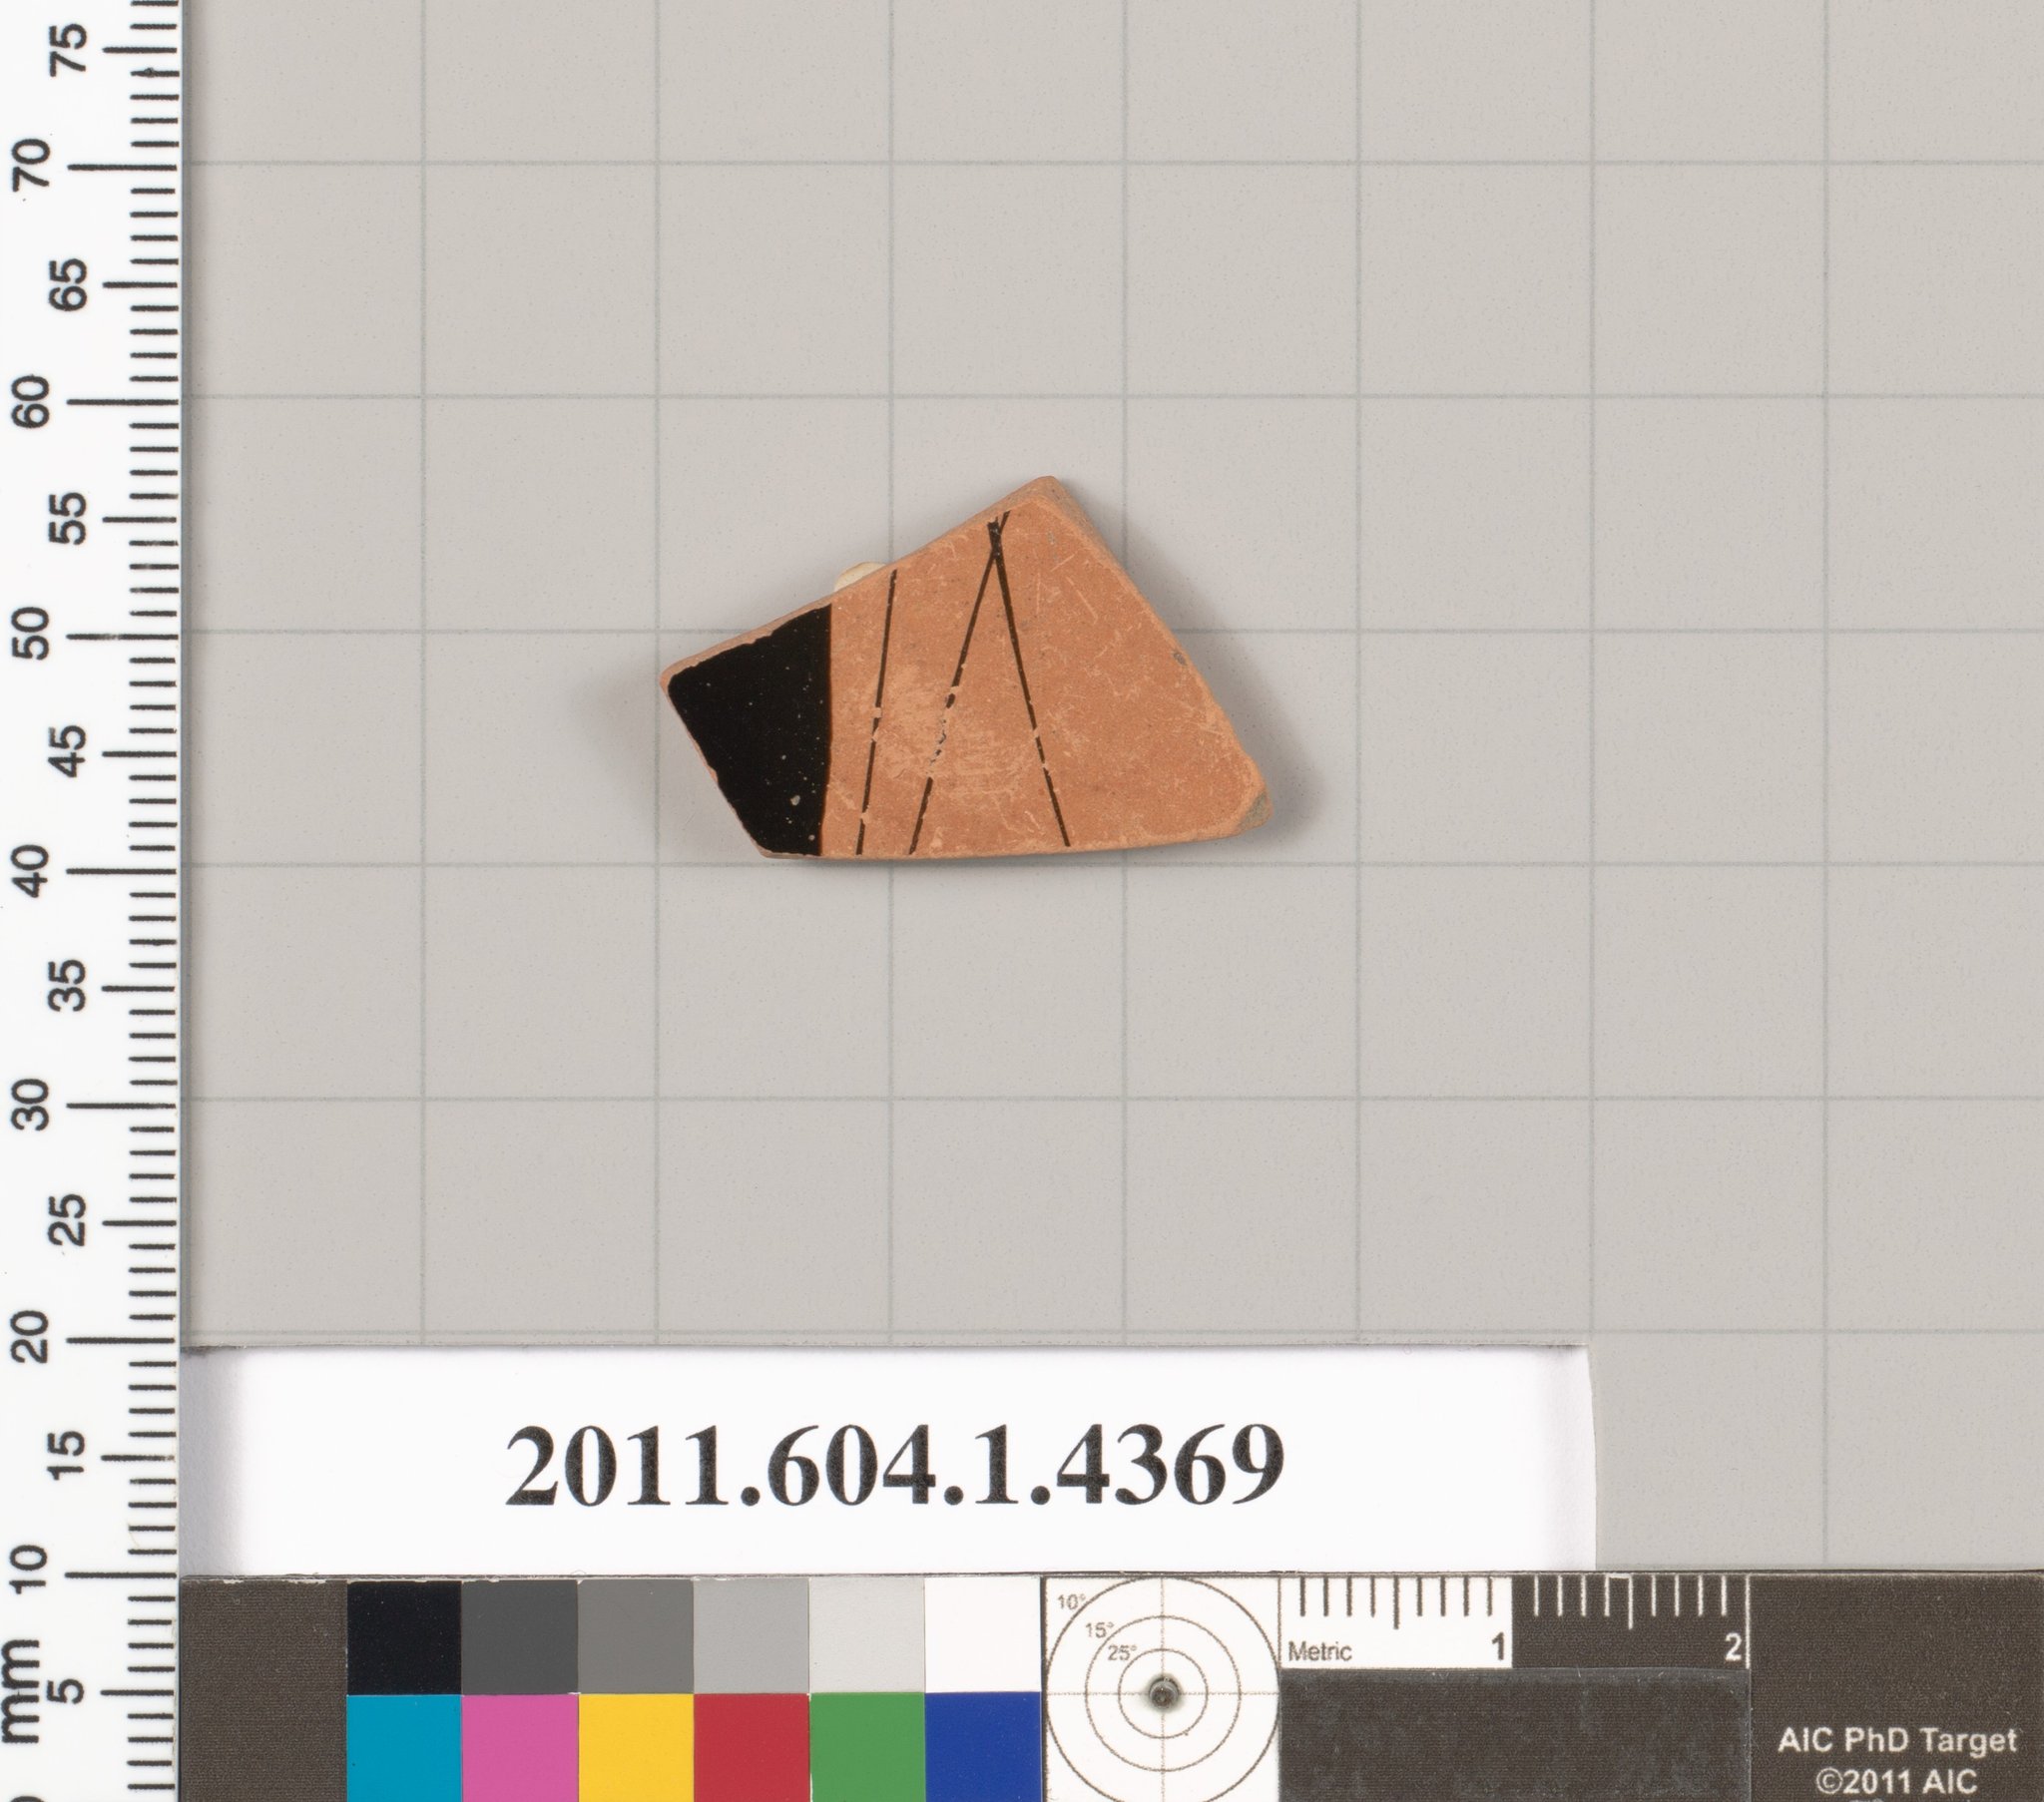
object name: kylix fragment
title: Terracotta fragment of a kylix (drinking cup)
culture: greek, attic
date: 490-470 BCE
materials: terracotta